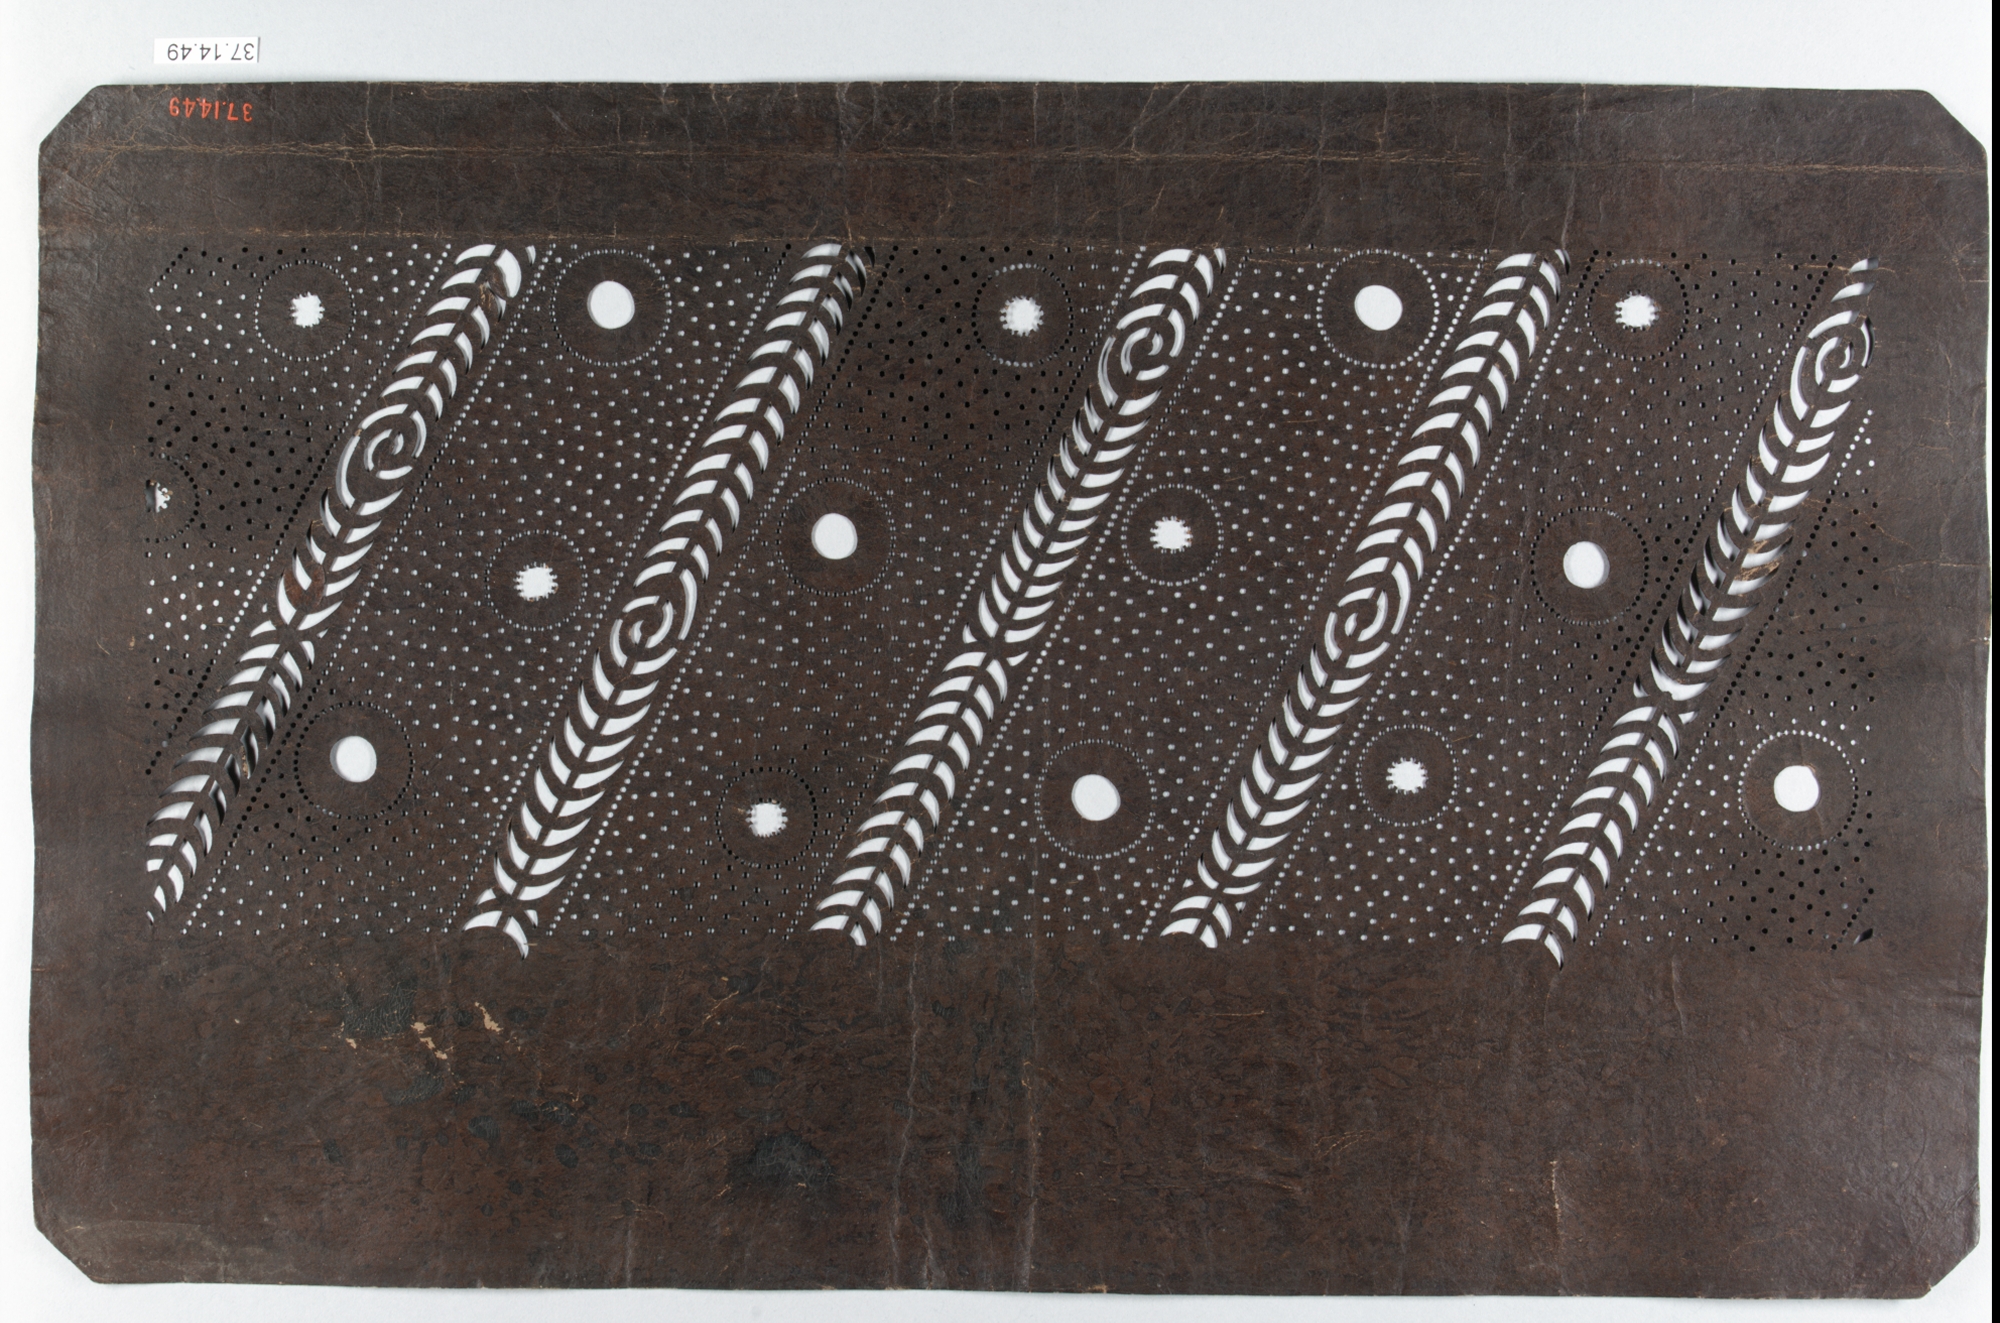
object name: stencil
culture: japanese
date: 1801-1833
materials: paper